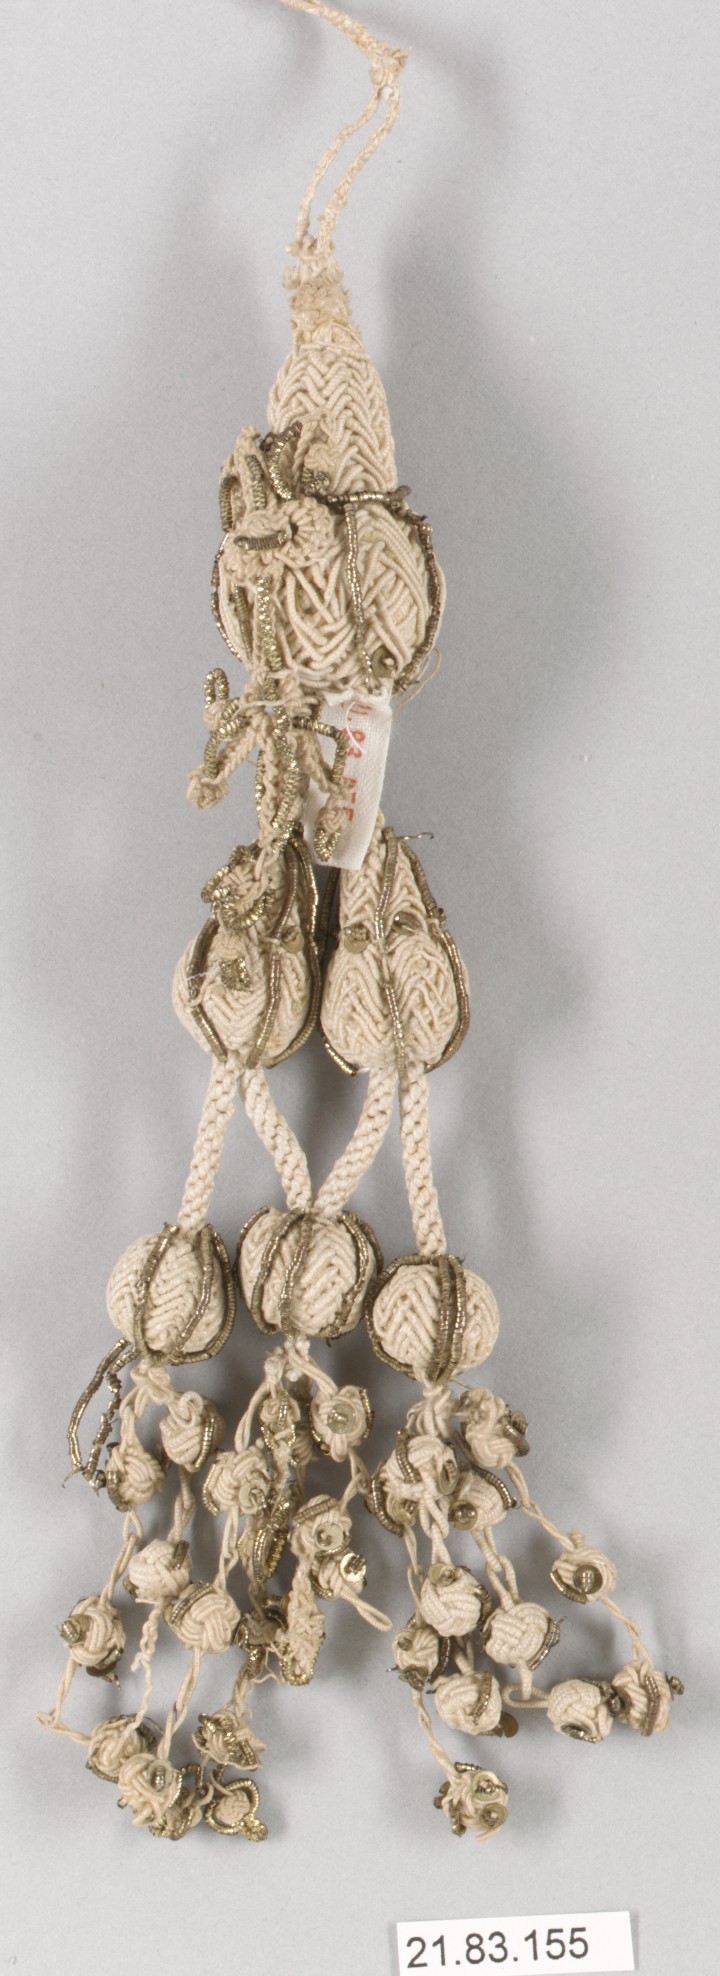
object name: tassel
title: Pair of tassels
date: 1601-1700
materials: linen